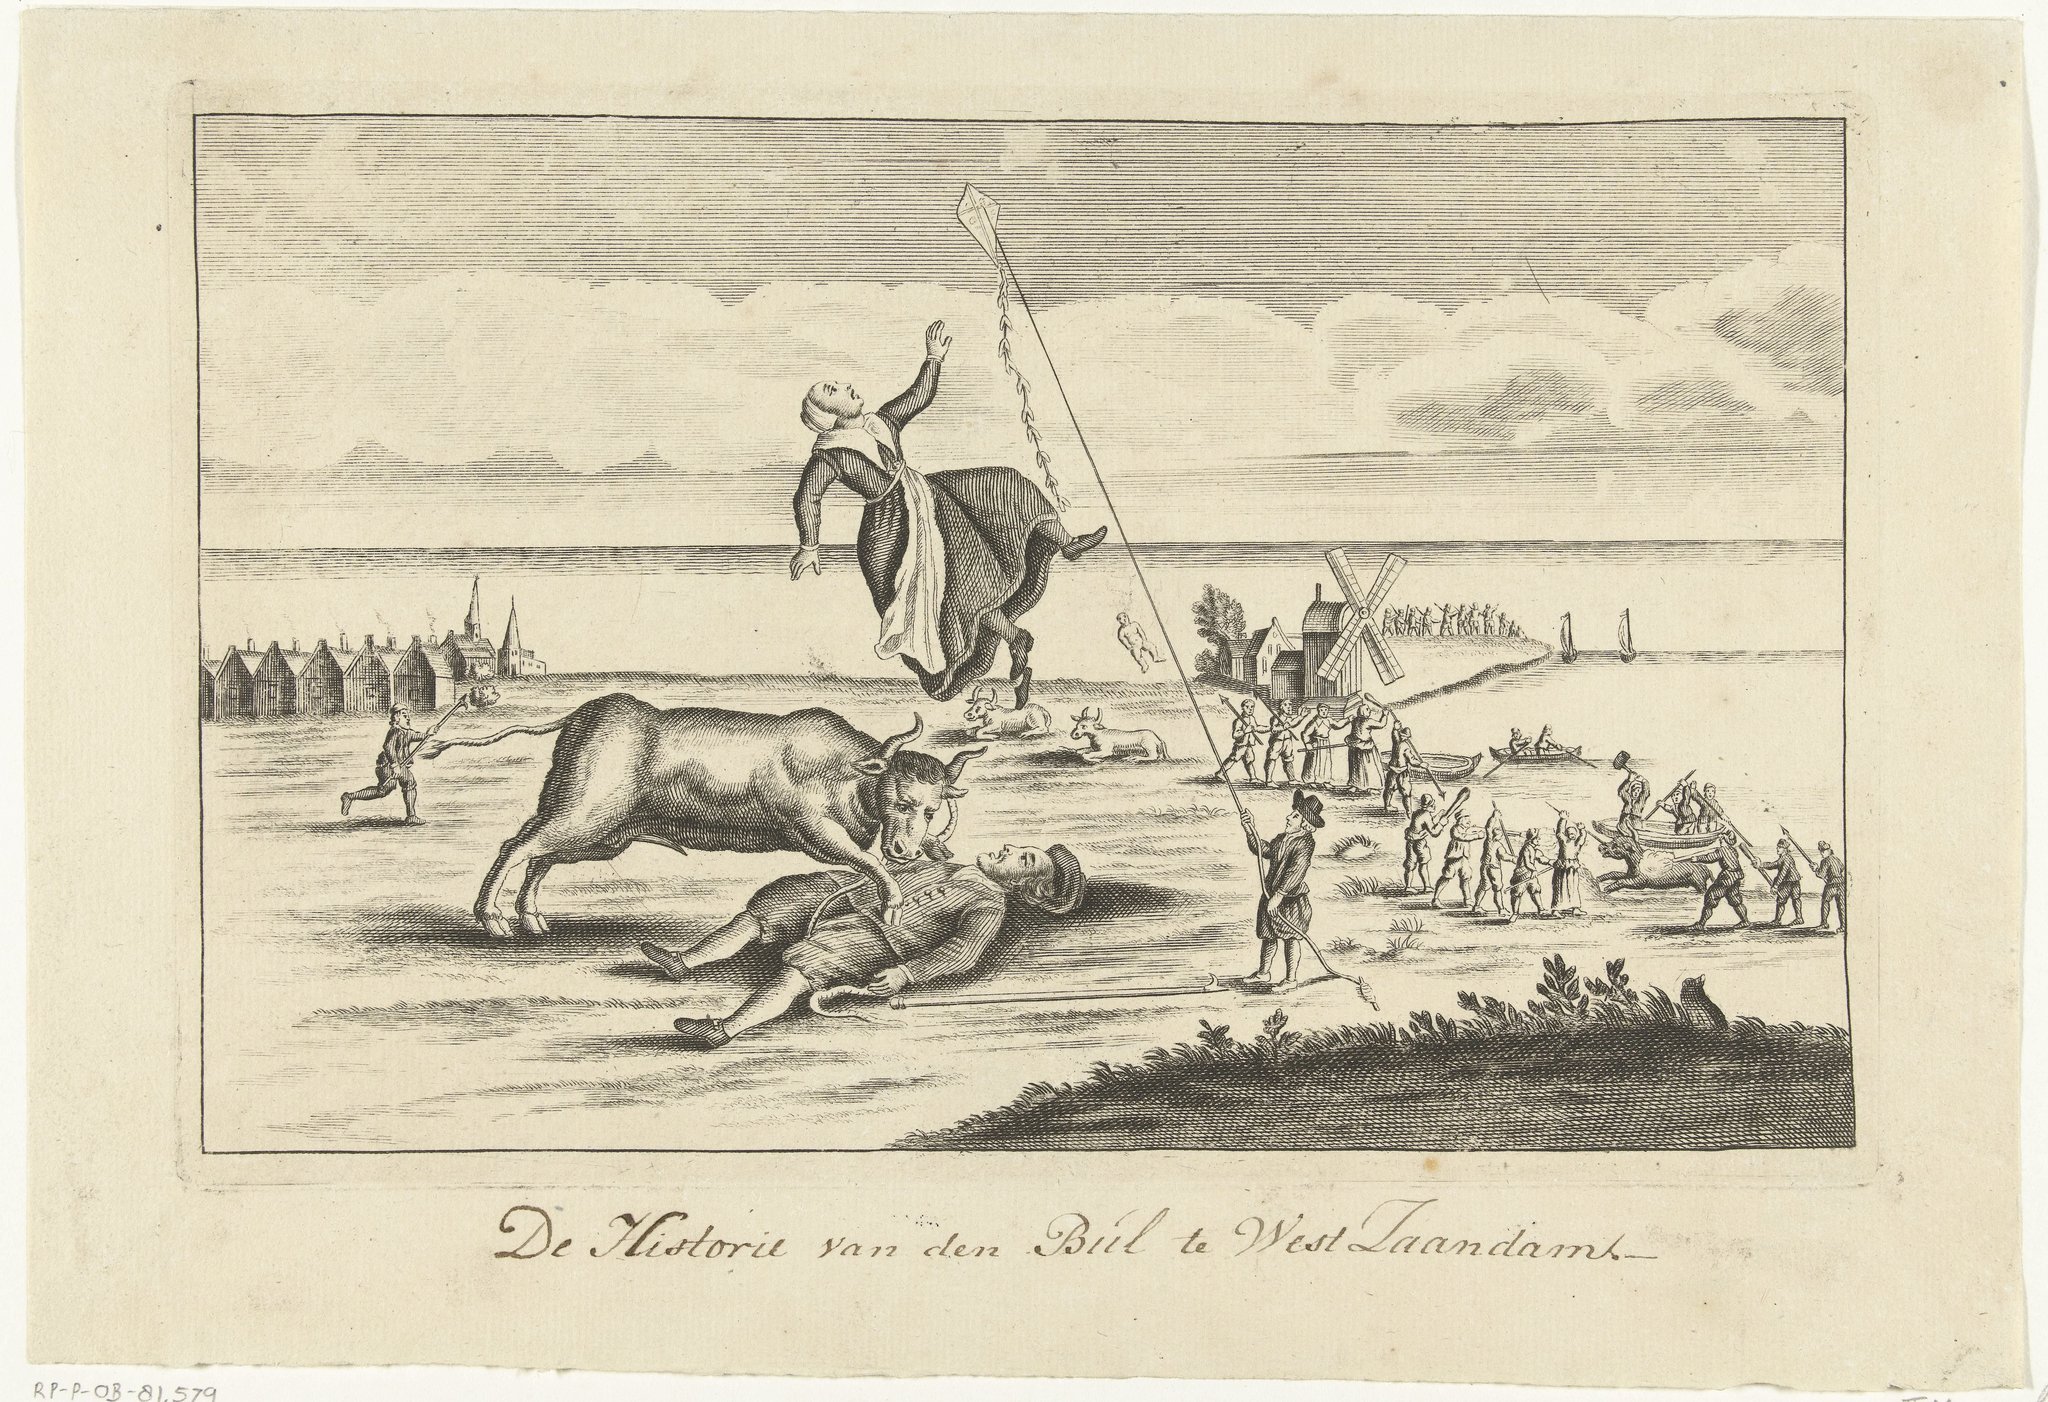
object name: history print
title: De wreedheid van de stier, 1647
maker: Anonymous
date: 1750-1850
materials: paper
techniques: engraving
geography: netherlands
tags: bull, difficult and unusual birth, (flying a) kite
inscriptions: inscription: ‘De Historie van den Bul te West Zaandam’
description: Illustratie van de gebeurtenissen die bekend staan als de wreedheid van de stier, 1647. De boer en zijn zwangere echtgenote die op 29 augustus 1647 te Zaandam door een stier werden aangevallen. De vrouw wordt door de stier op de horens genomen waarbij het kind uit de buik wordt geslingerd.